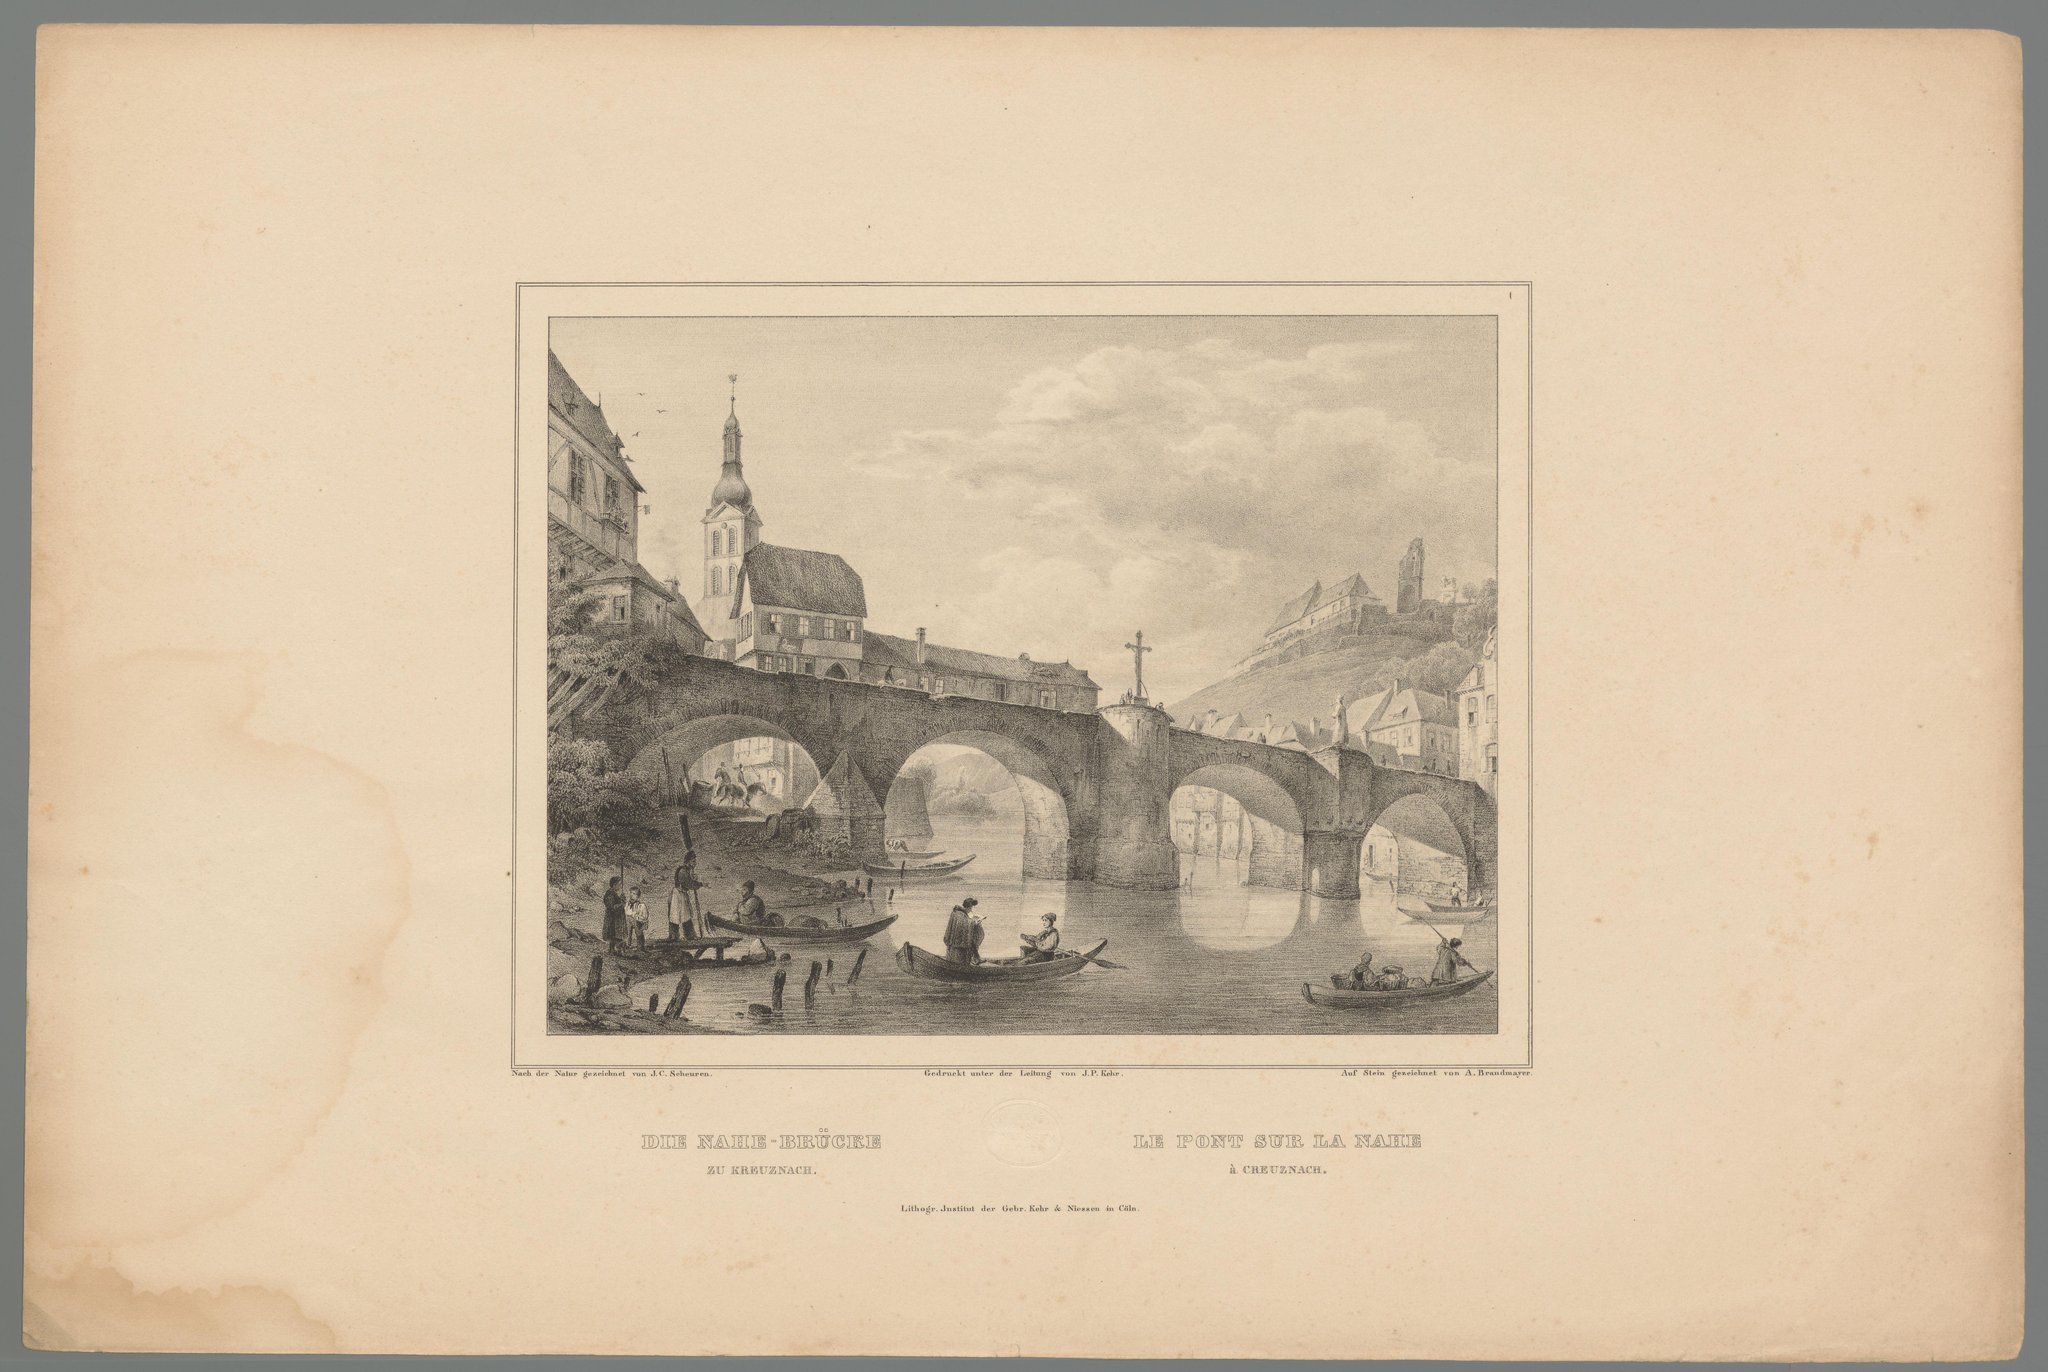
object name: print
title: Gezicht op een brug over de Nahe bij Kreuznach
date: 1834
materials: paper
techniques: lithograph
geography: cologne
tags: rowing-boat, canoe, etc., village (+ city(-scape) with figures, staffage), bridge in village across river, canal, etc.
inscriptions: check stamp: ‘Verlag von L. Niessen in Cöln’, collector's mark: Lugt 2228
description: De serie 'Das Nahe-Thal. Von dem Ursprunge der Nahe bis zu ihrer Mündung in den Rhein' is uitgegeven in vijf delen van elk vier prenten vervaardigd door A. Brandmayer en Andreas Borum. Tien prenten uit deze serie zijn daarnaast waarschijnlijk ook nog samen onder de titel 'Kreuznach und seine Umgebung. Erinnerung an seine Heilquellen und das Nahe-Thal' uitgegeven.